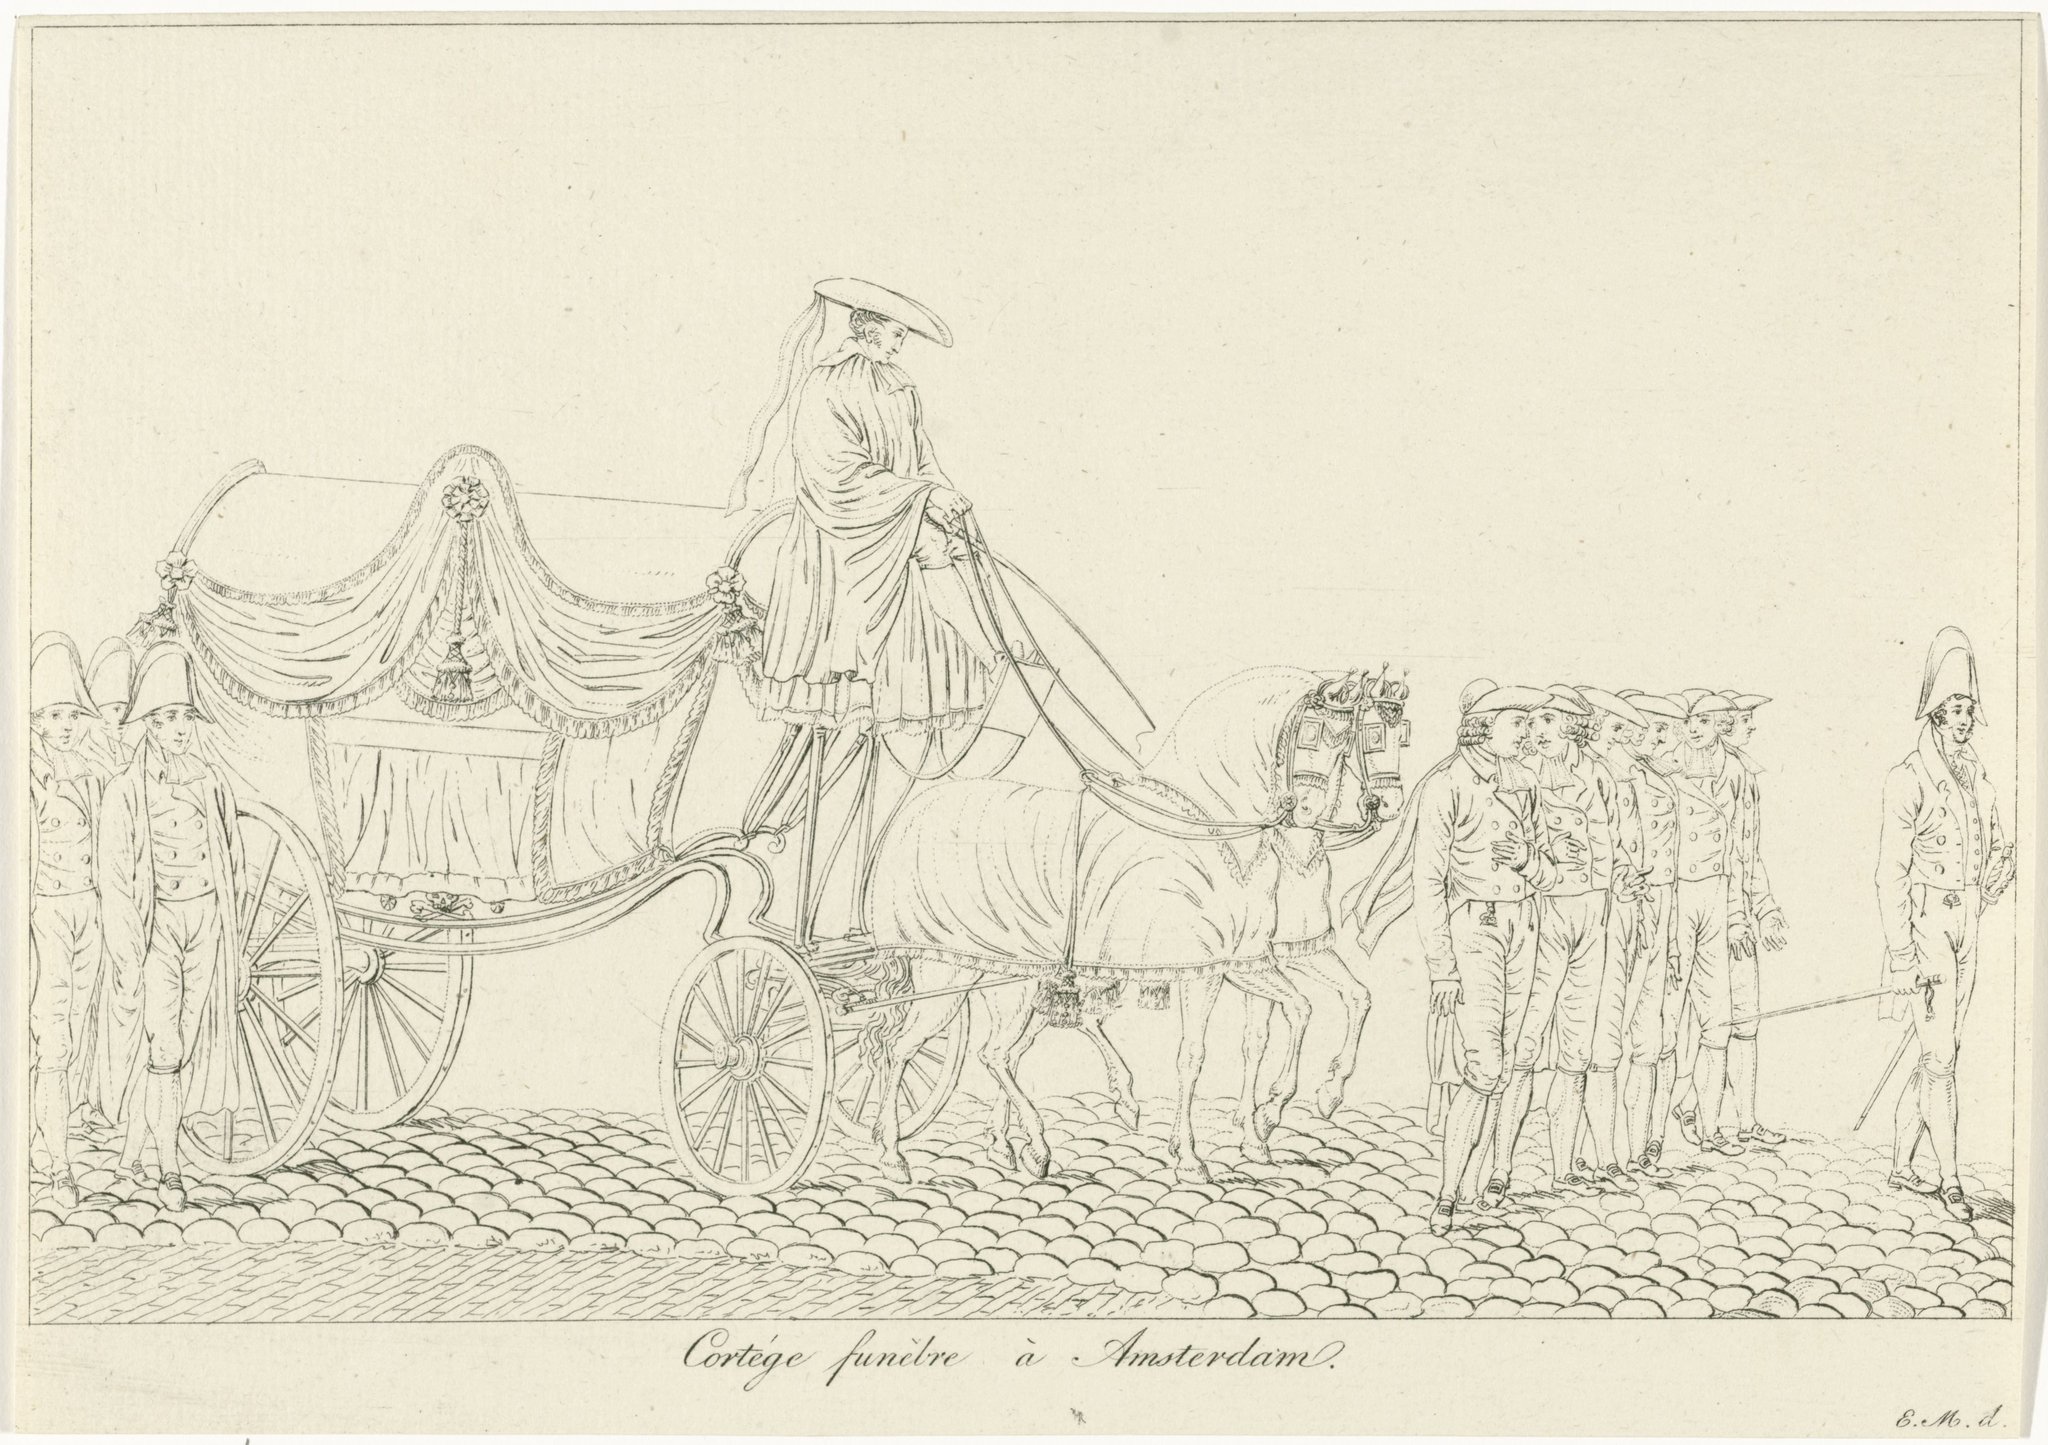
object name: print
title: Cortége funèbre à Amsterdam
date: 1816-1833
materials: paper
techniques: etching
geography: amsterdam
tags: cortege, funeral procession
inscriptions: collector's mark: Lugt 2228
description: Prent ook gebruikt in: Maaskamp, Evert. Tableau des principales vues des palais et édifices : représentations et des coutumes et usages, dans les provinces septentrionales du Royaume des Pays-Bas. Amsterdam, Evert Maaskamp, 1824.